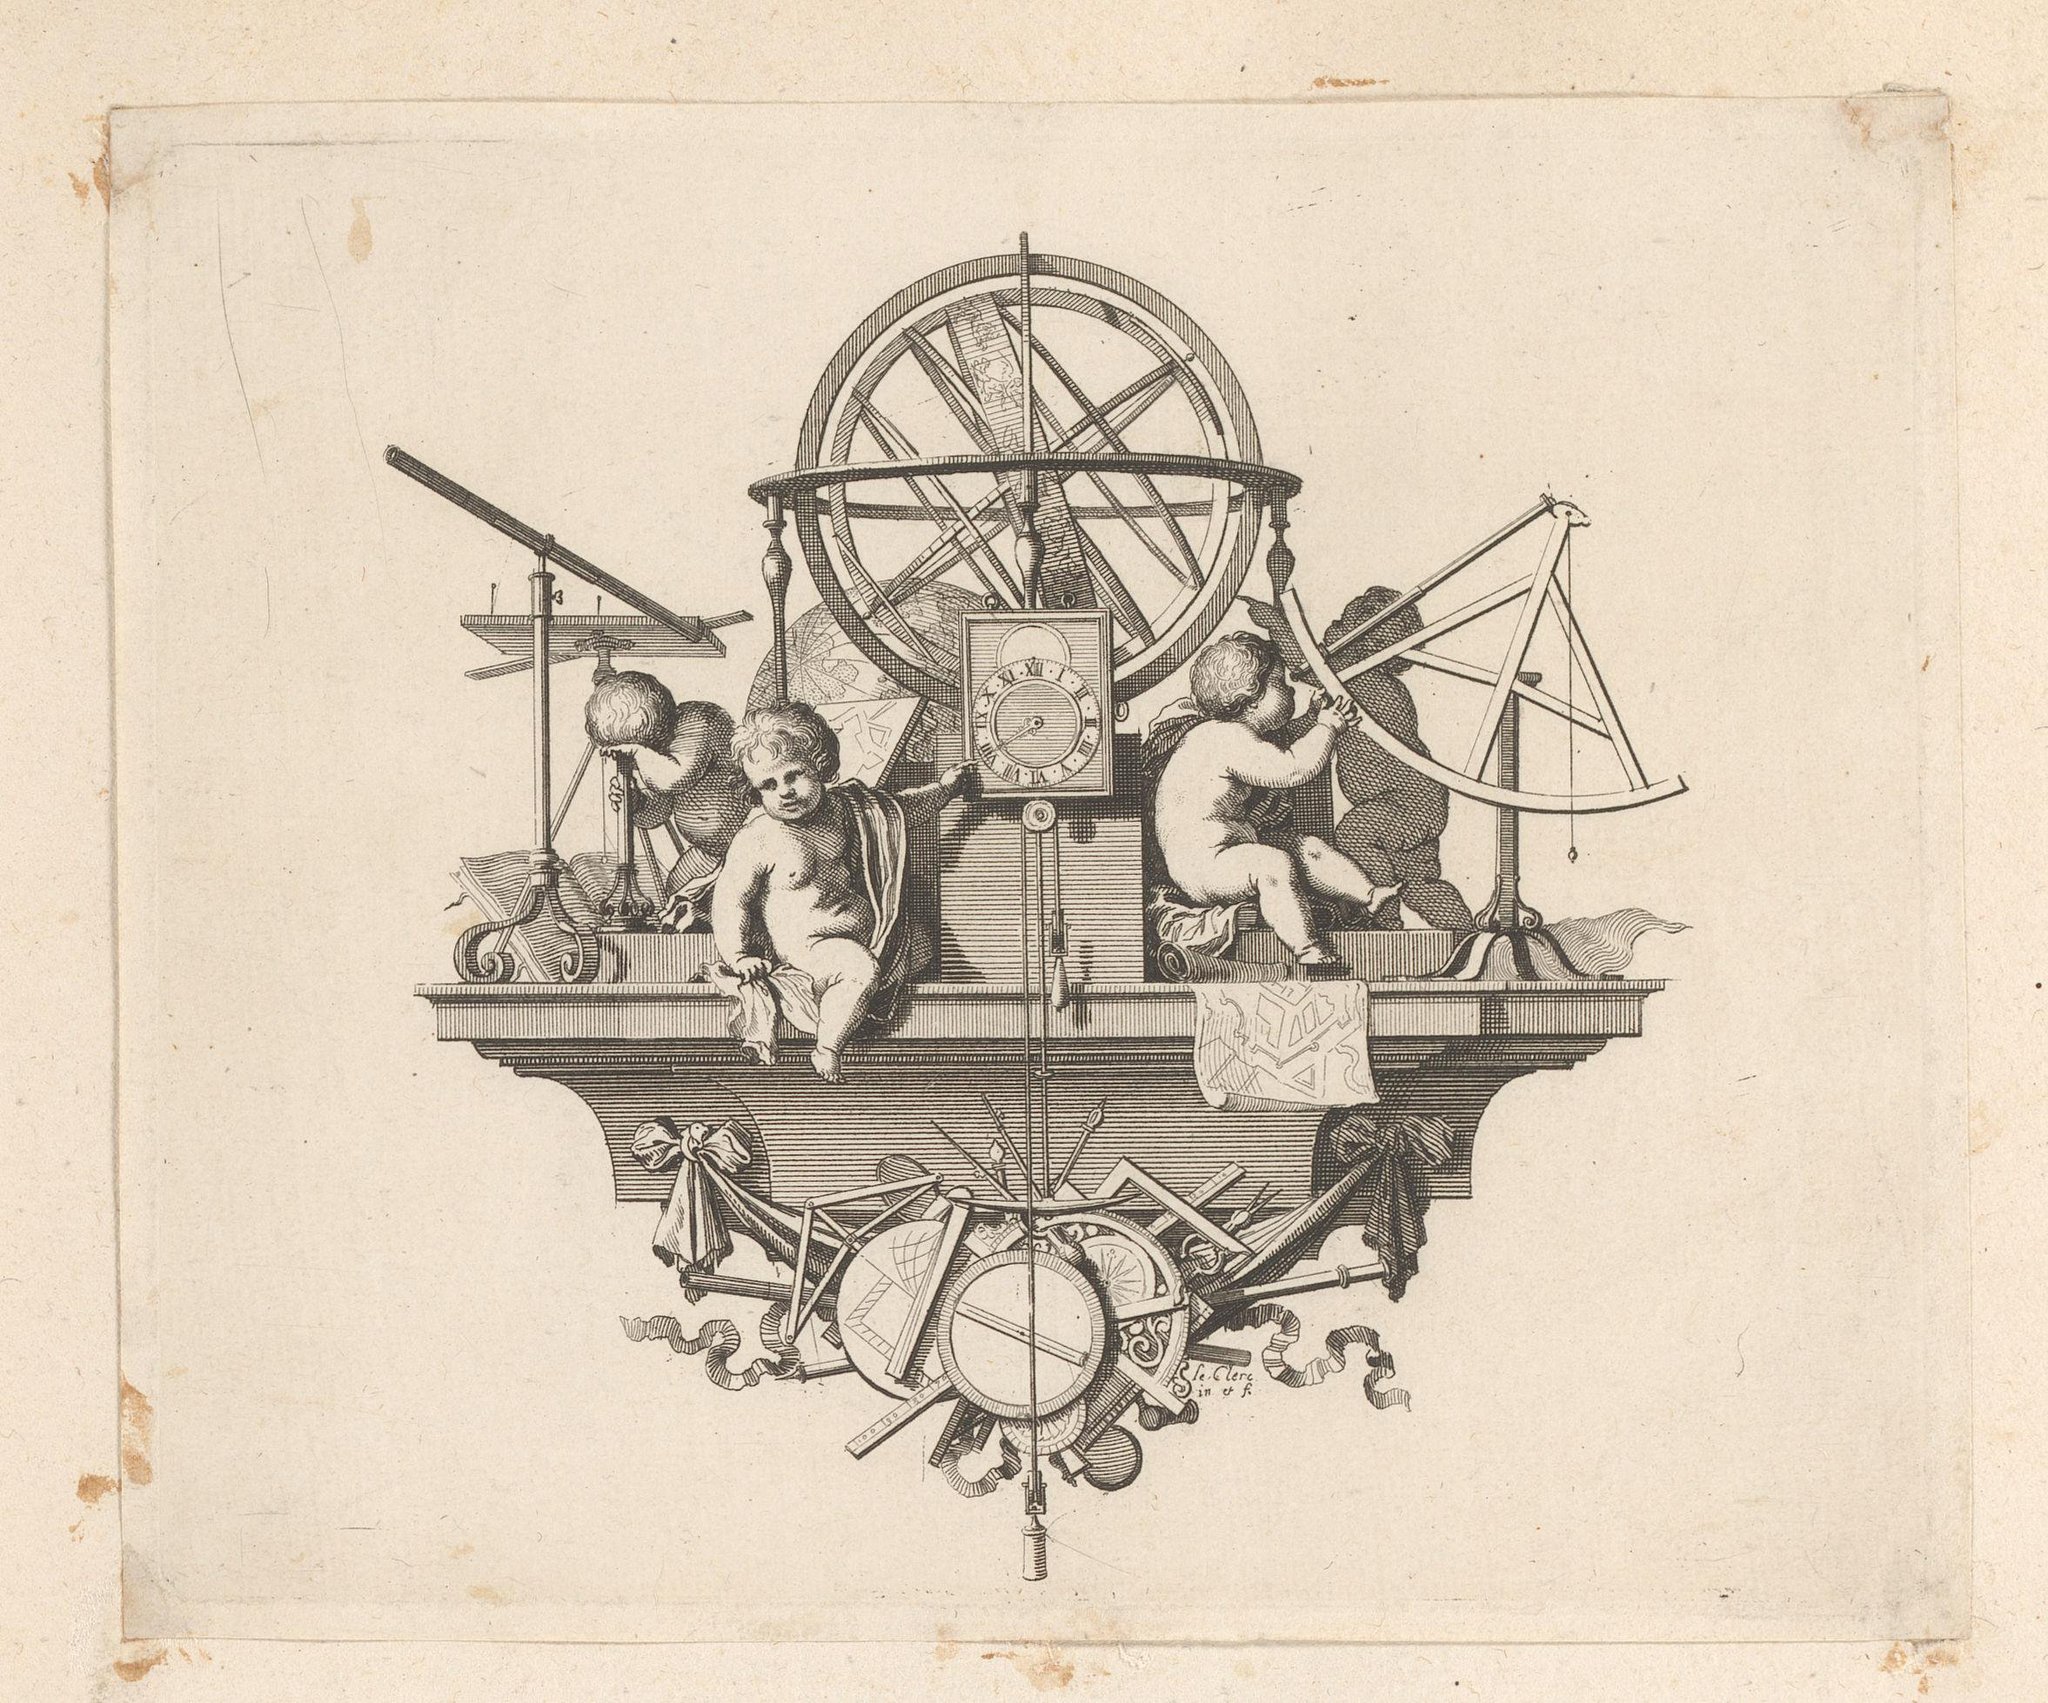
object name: album leaf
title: Cul-de-lampe met vier putti met meetinstrumenten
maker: sébastien leclerc (i)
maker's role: print maker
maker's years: 1637-1714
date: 1671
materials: paper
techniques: etching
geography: paris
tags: measuring-instruments, cupids: 'amores', 'amoretti', 'putti'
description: Prent uit: Picard, Abbé Jean. Mesure de la terre. Parijs: Imprimerie Royale, 1671.